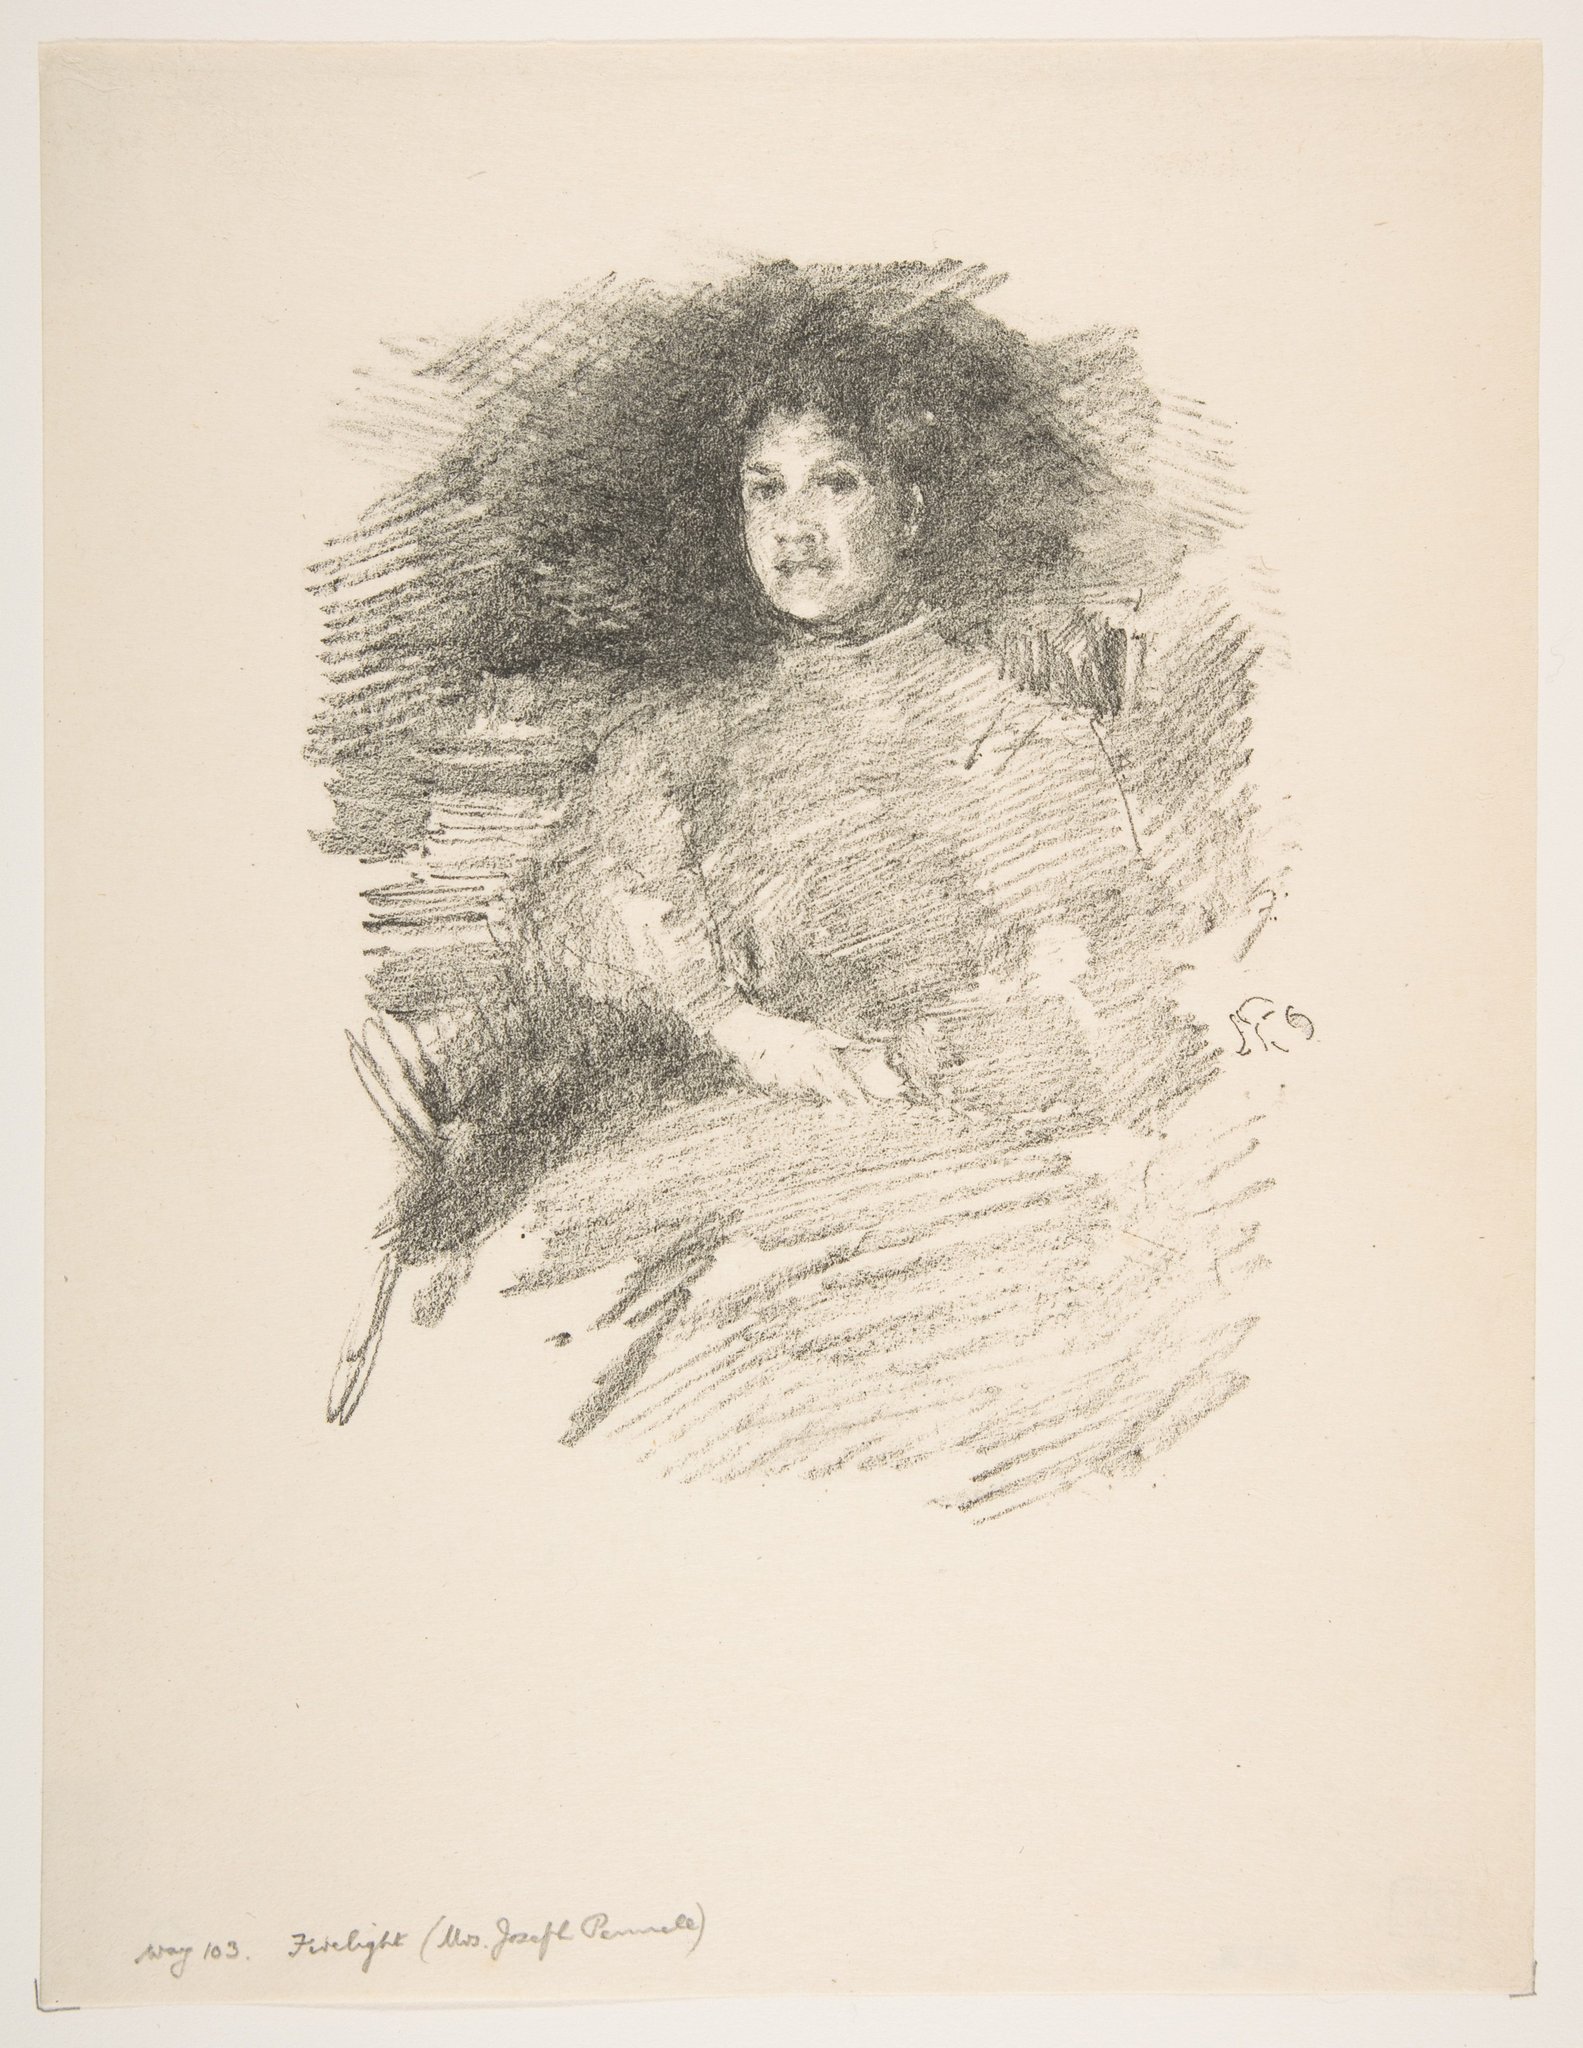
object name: print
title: Firelight (Mrs. Joseph Pennell)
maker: james mcneill whistler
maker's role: artist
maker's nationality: american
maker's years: 1834-1903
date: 1896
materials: ink, paper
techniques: printing, lithography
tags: women